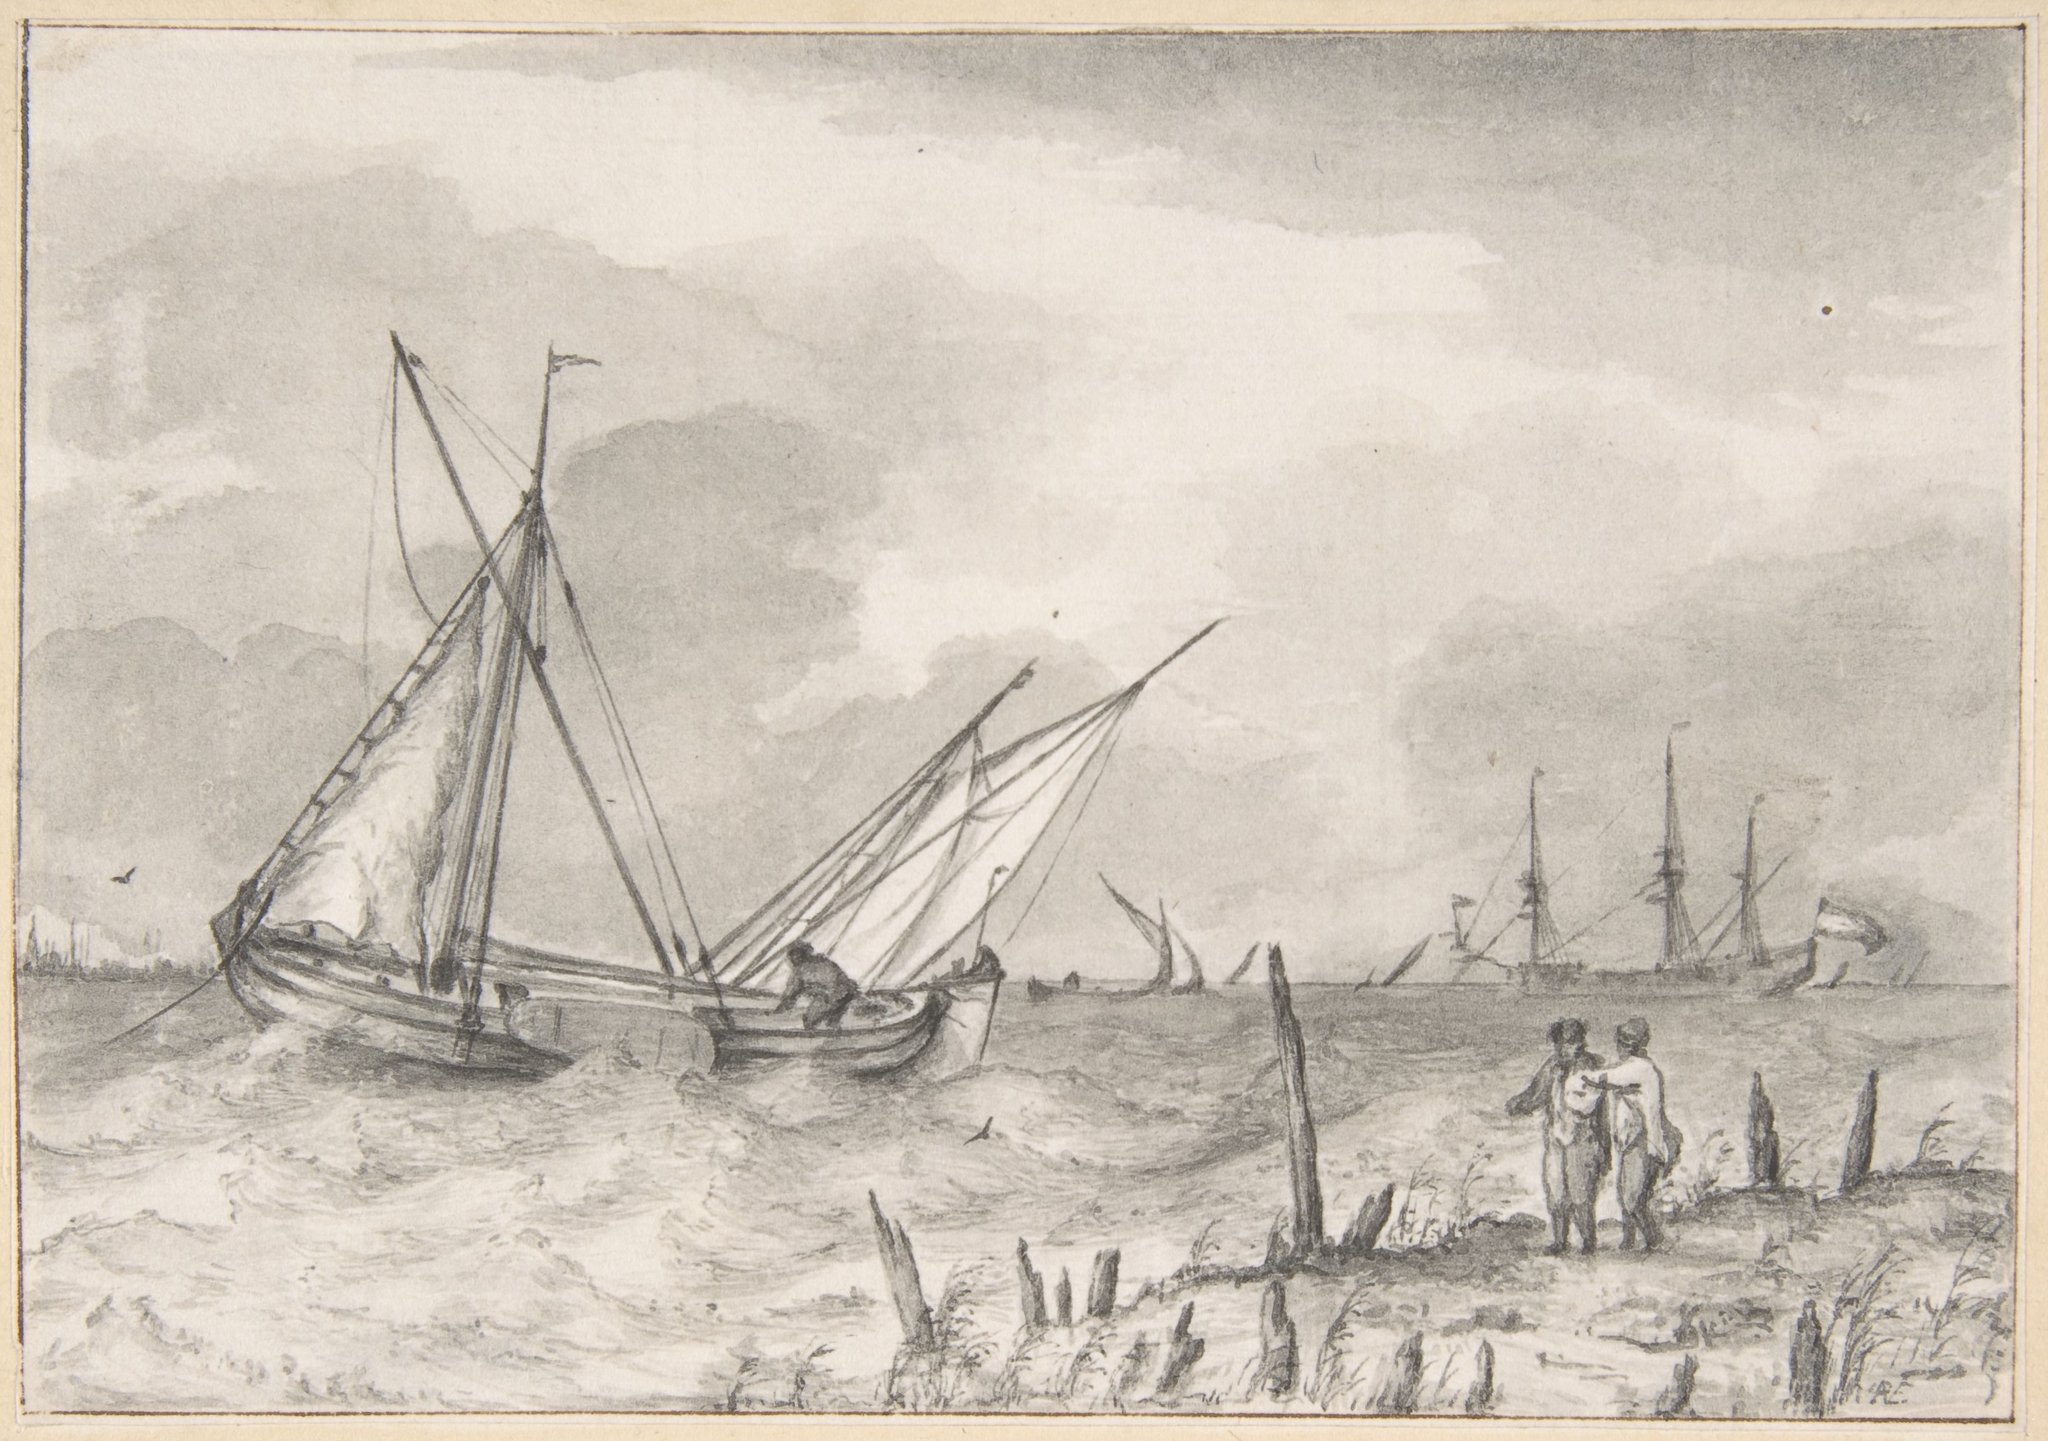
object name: drawing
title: Choppy Sea with Boats near the Coast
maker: pieter van everdingen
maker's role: artist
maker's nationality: dutch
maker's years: 1653-1739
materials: ink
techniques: pen, wash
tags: boats